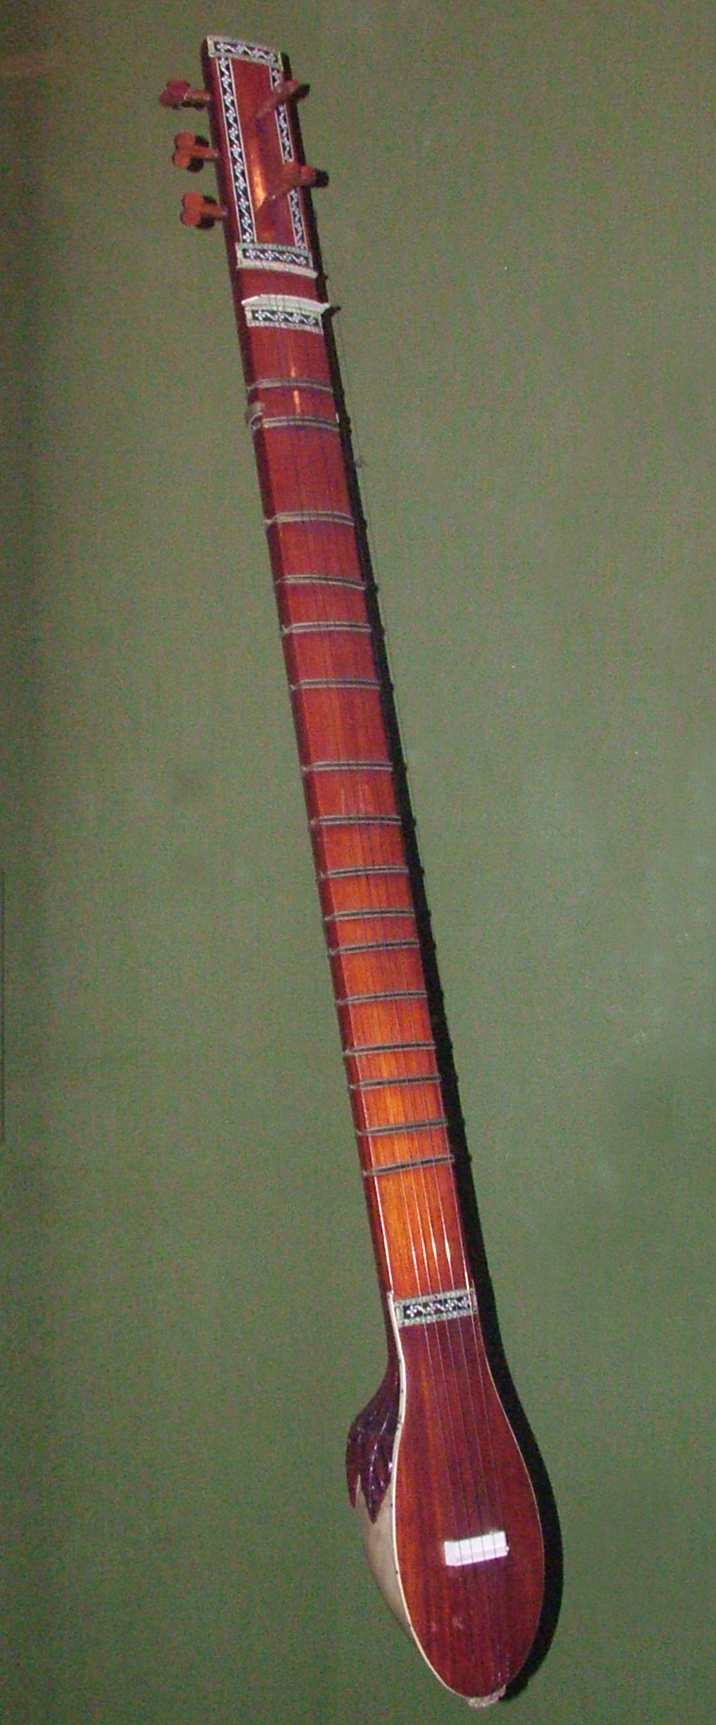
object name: sitar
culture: indian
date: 1867-1900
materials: shell, wood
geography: india